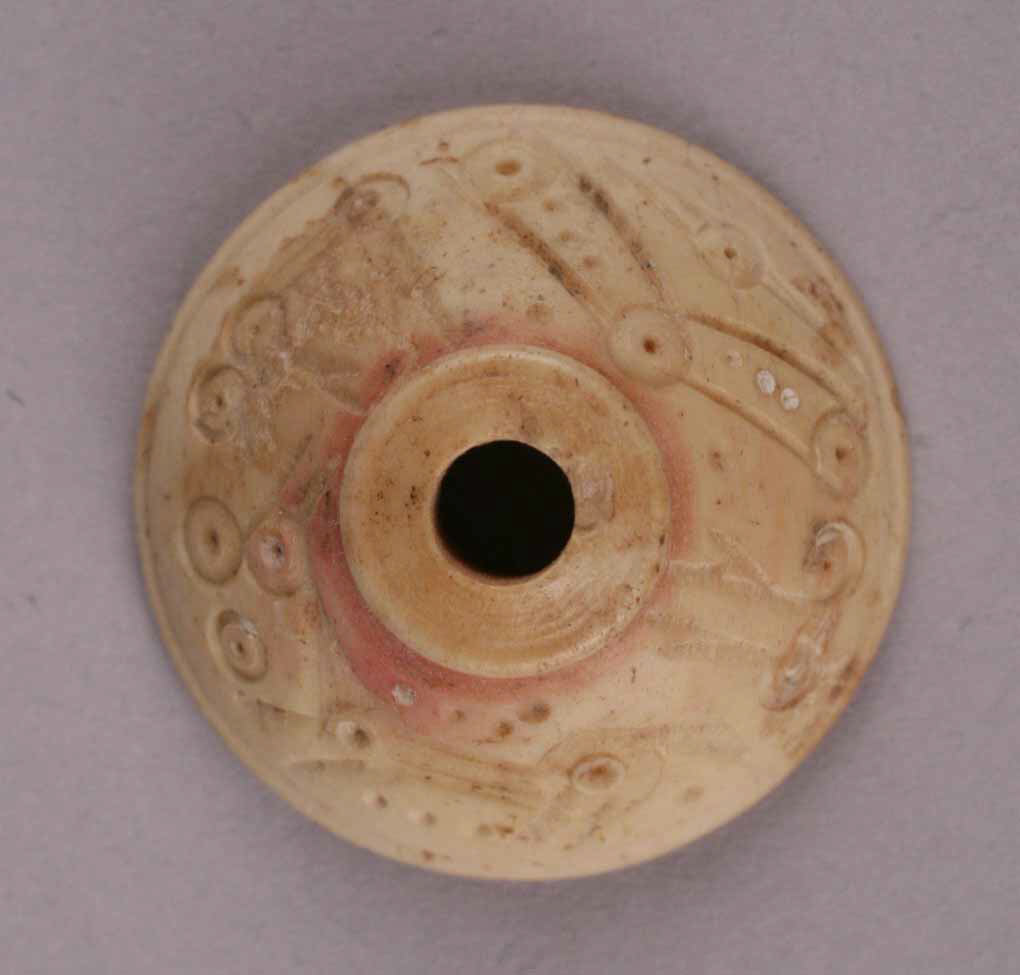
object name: button or bead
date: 801-1000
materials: bone, paint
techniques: incising, inlay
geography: iran